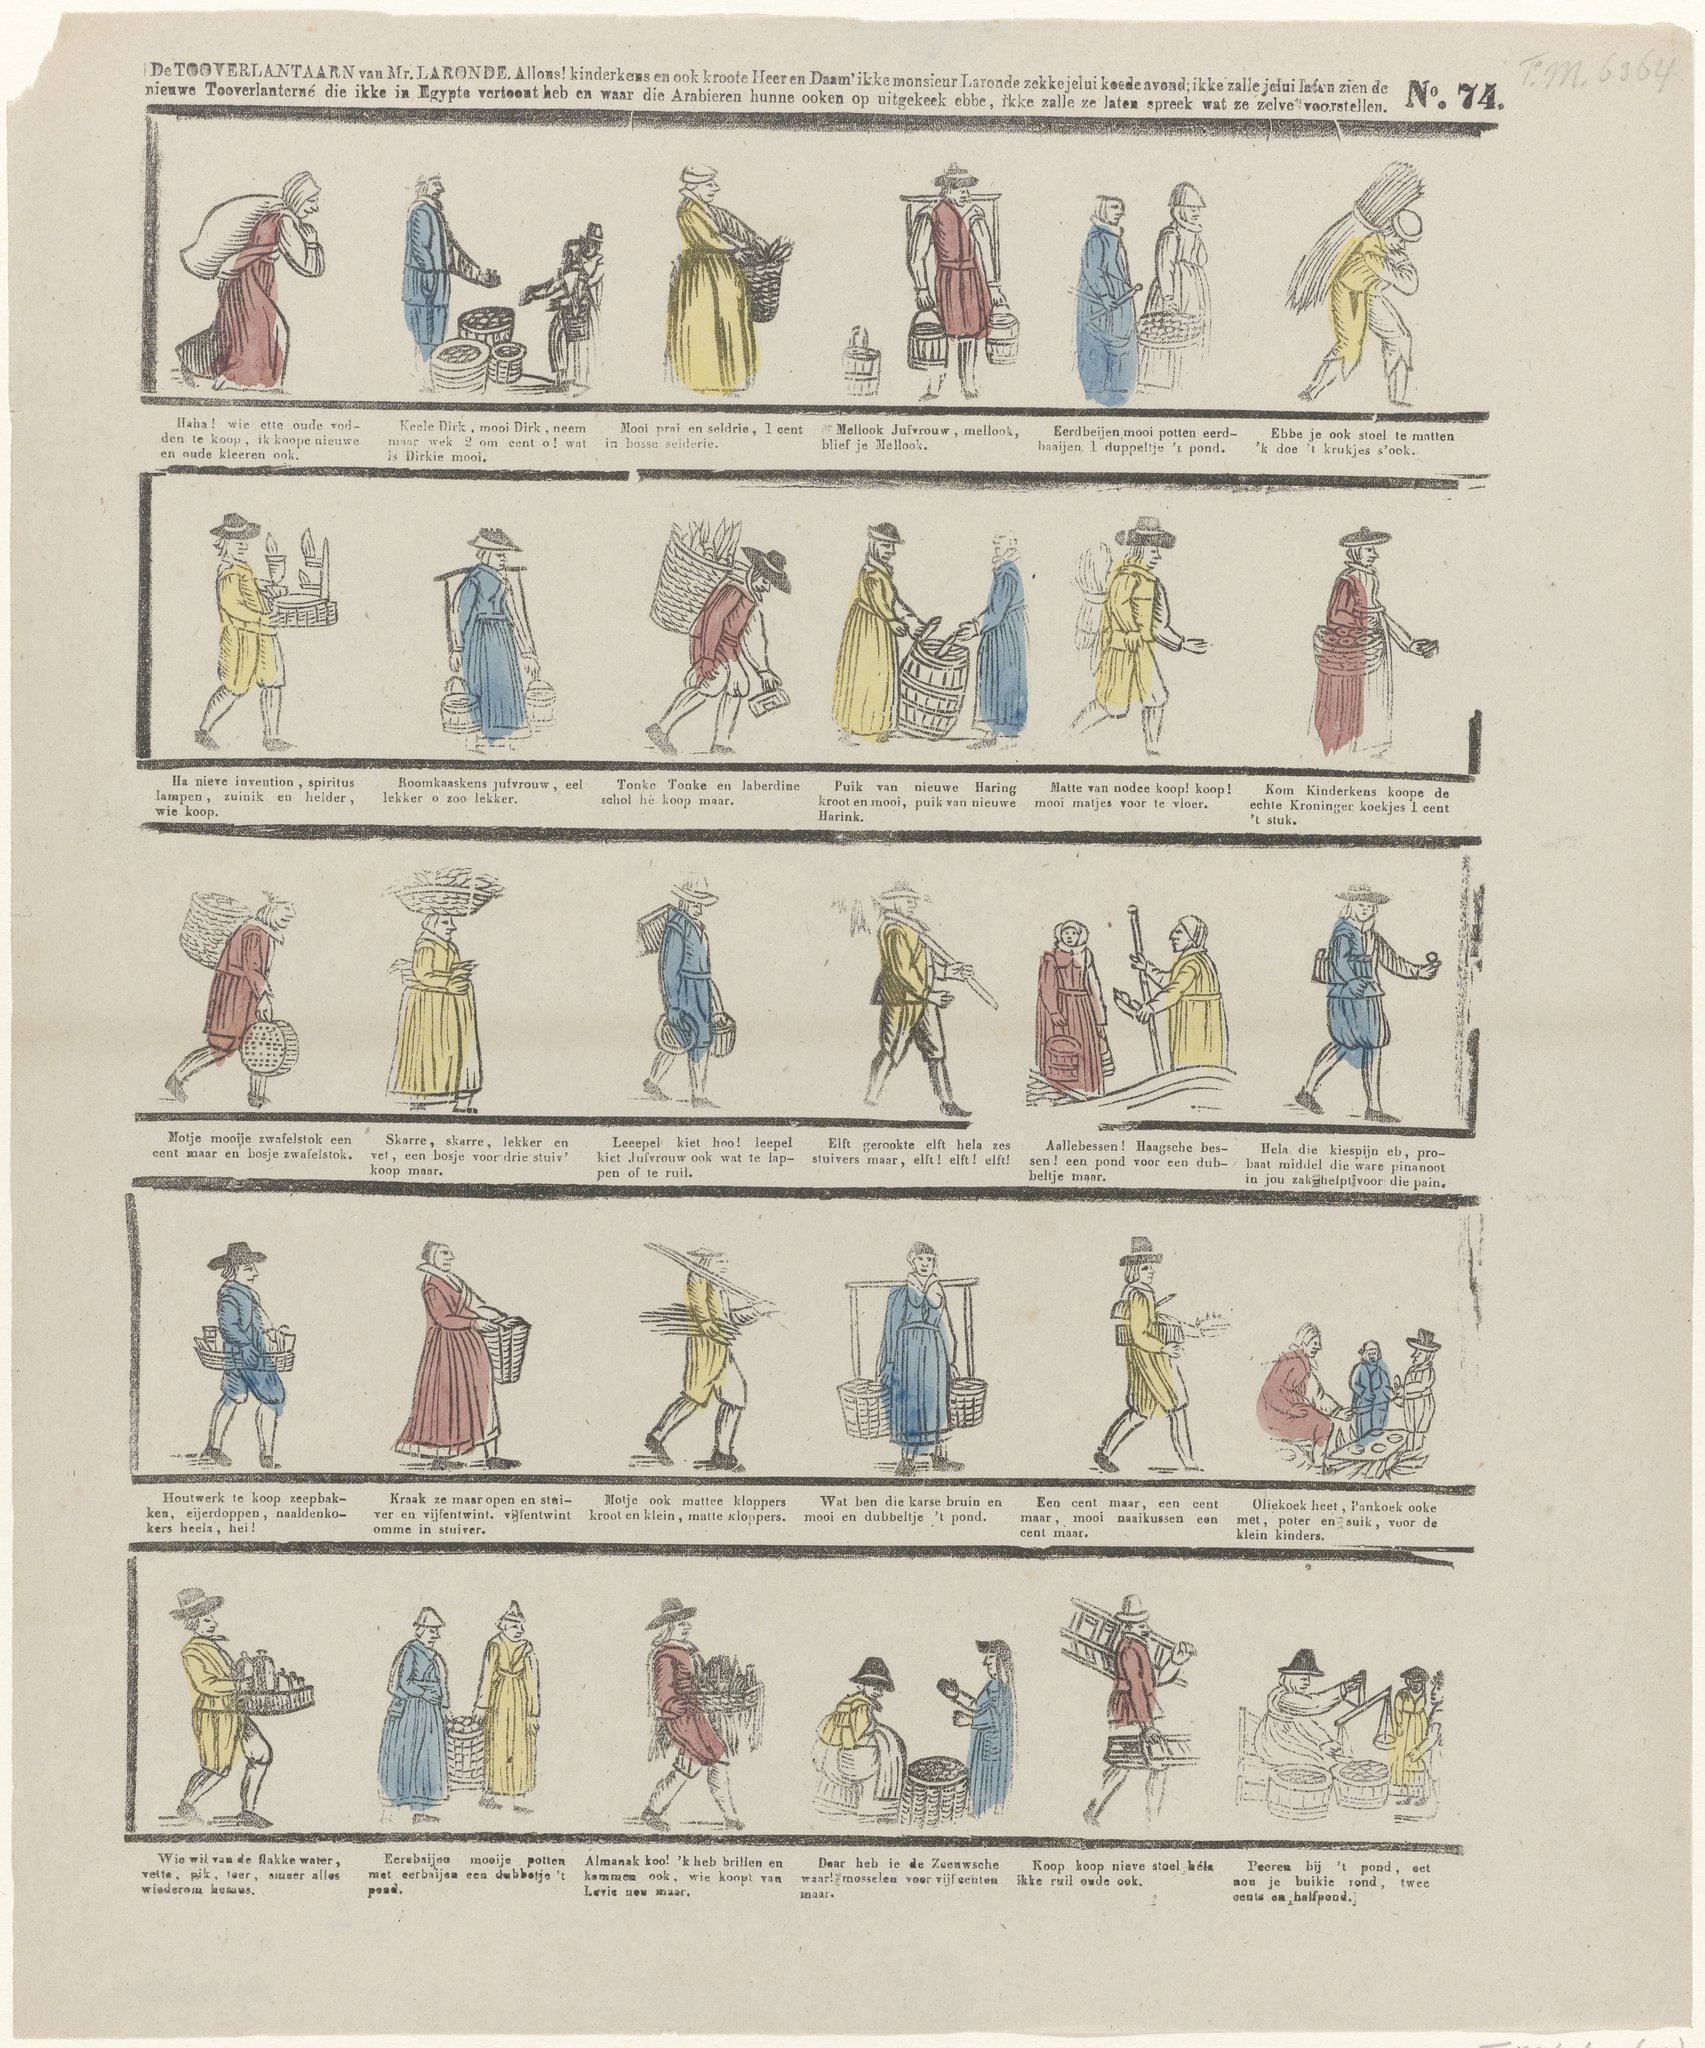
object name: print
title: De Tooverlantaarn van Mr. Laronde. Allons! kinderkens en ook kroote Heer en Daam (...)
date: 1850-1870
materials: paper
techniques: colour, letterpress printing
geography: amsterdam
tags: persons engaged in trade and commerce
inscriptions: collector's mark: Lugt 2228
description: Blad met vijf blokken met in totaal dertig toverlantaarnplaatjes van verschillende beroepen, handelaren of bezigheden, mannen en vrouwen. Onder elk plaatje een twee- of drieregelig versje. Genummerd rechtsboven: No. 74. Ca. 1800-1850.